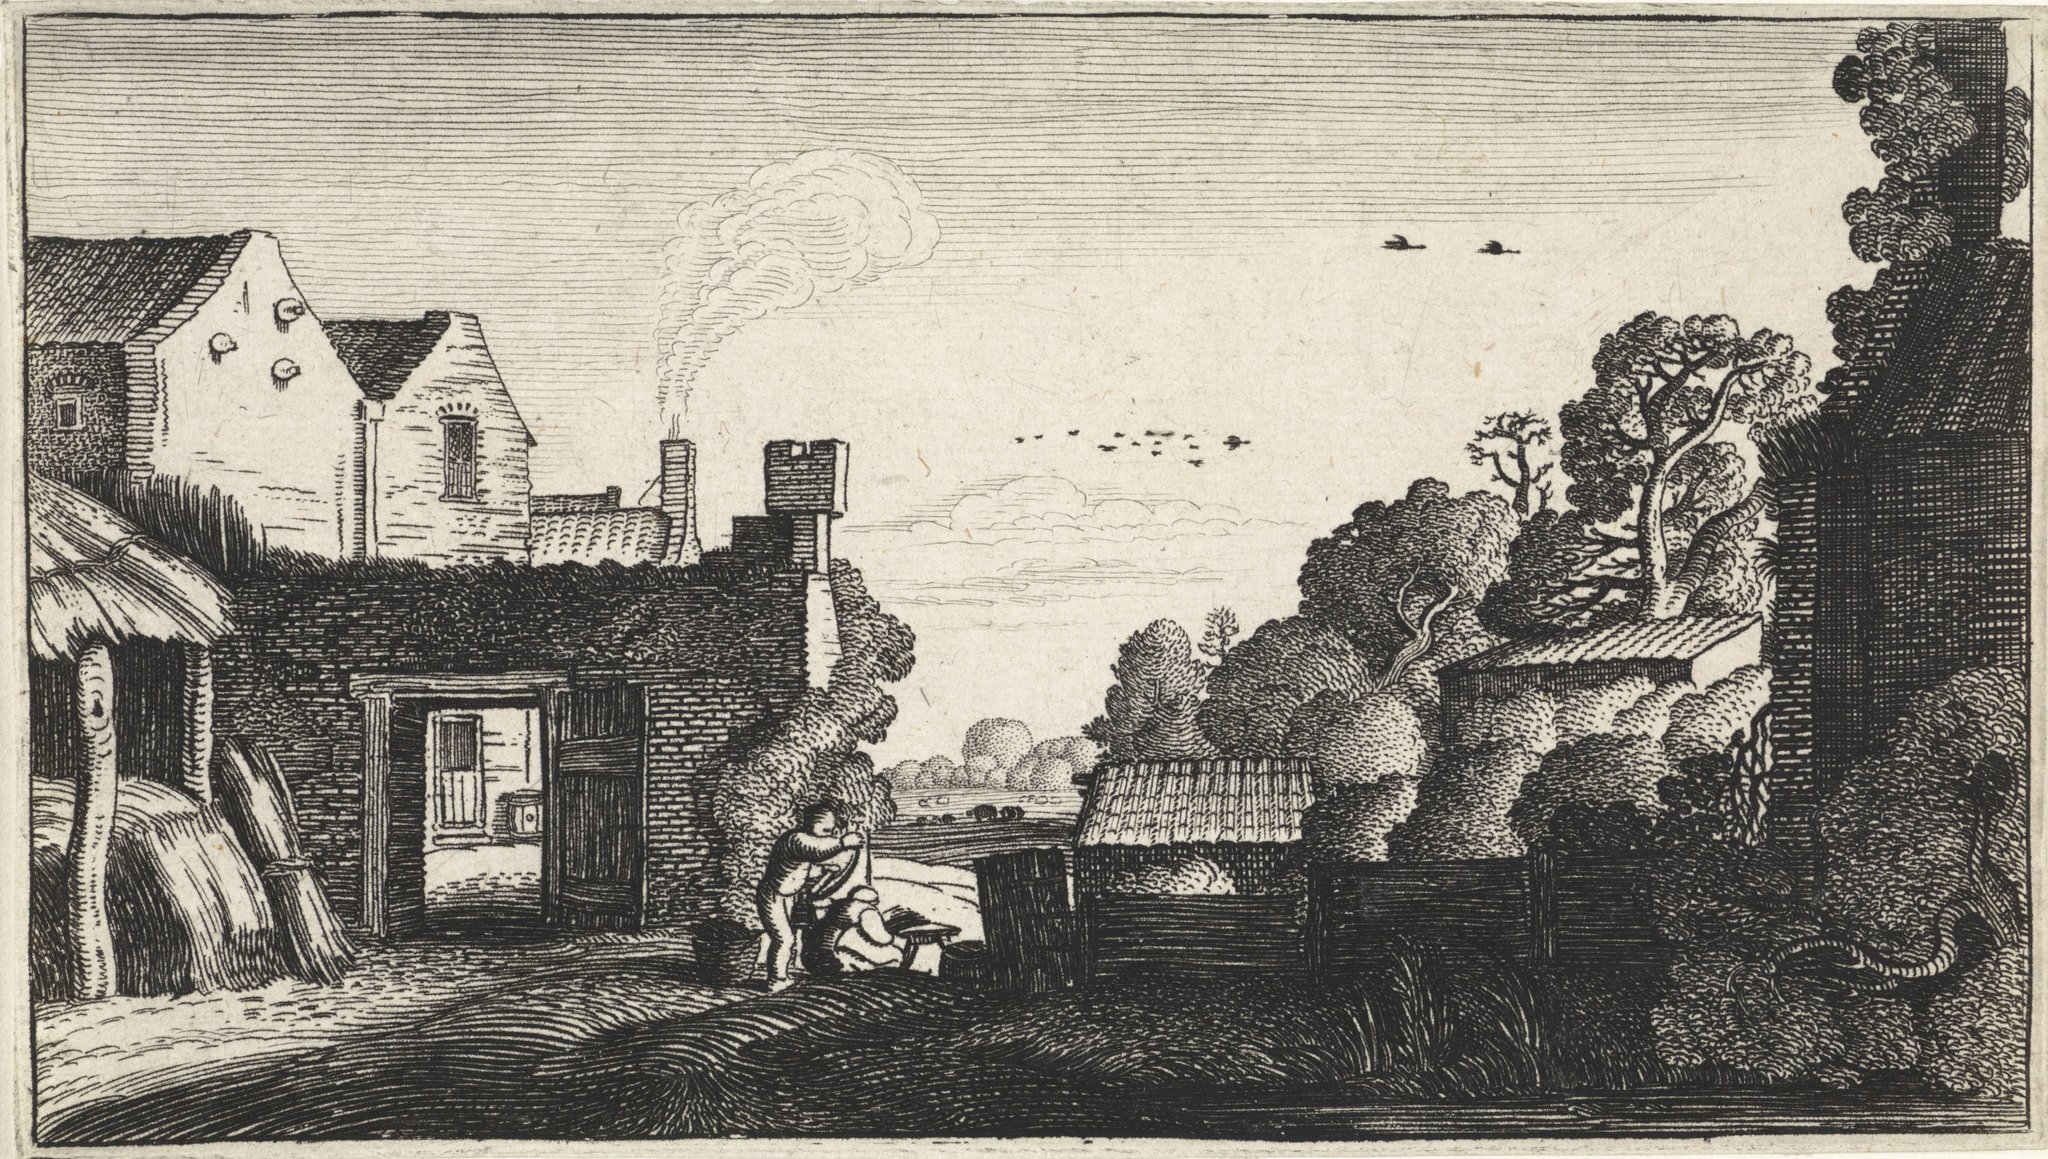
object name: print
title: Binnenplaats met hooiberg en twee figuren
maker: jan van de velde (ii)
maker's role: draughtsman, painter, print maker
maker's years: 1593-1641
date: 1603-1641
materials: paper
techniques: engraving, etching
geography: northern netherlands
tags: annexes and outbuildings; fencing; gate, smoke-stack, courtyard, hay-stack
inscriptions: collector's mark: Lugt 240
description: Twee figuren op een binneplaats bij een huis met een poort. Zesde prent uit een serie van zes.